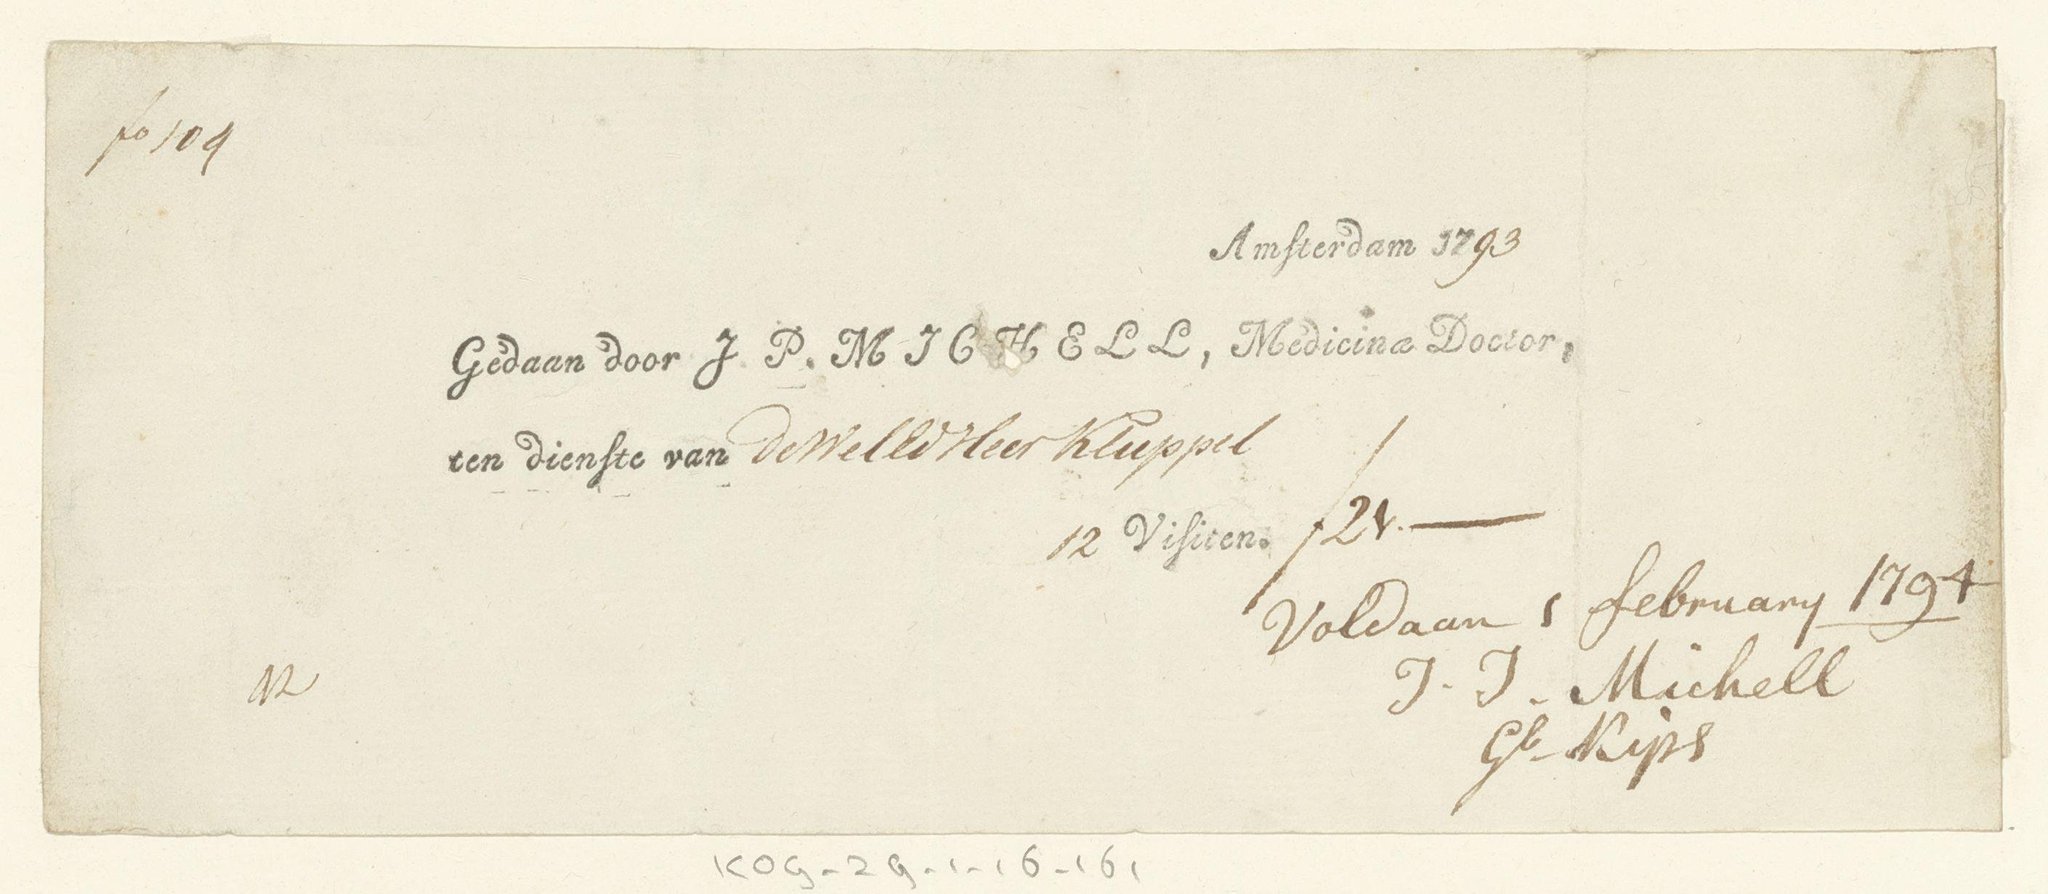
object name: account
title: Rekening van de geneesheer J.P. Michell, 1793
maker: Anonymous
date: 1793-1794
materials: ink, paper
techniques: letterpress printing, pen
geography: netherlands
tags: physician, doctor, medical examination, medical treatment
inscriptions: collector's mark: Lugt 1641, collector's mark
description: Rekening van de geneesheer J.P. Michell, Amsterdam 1793, voldaan 1 februari 1794. Voorgedrukte kwitantie, ingevuld met pen. Onderwerpsrubrieken binnen de Atlas Zeden en Gewoonten: Onderwijs en Wetenschappen: Geneeskunde.